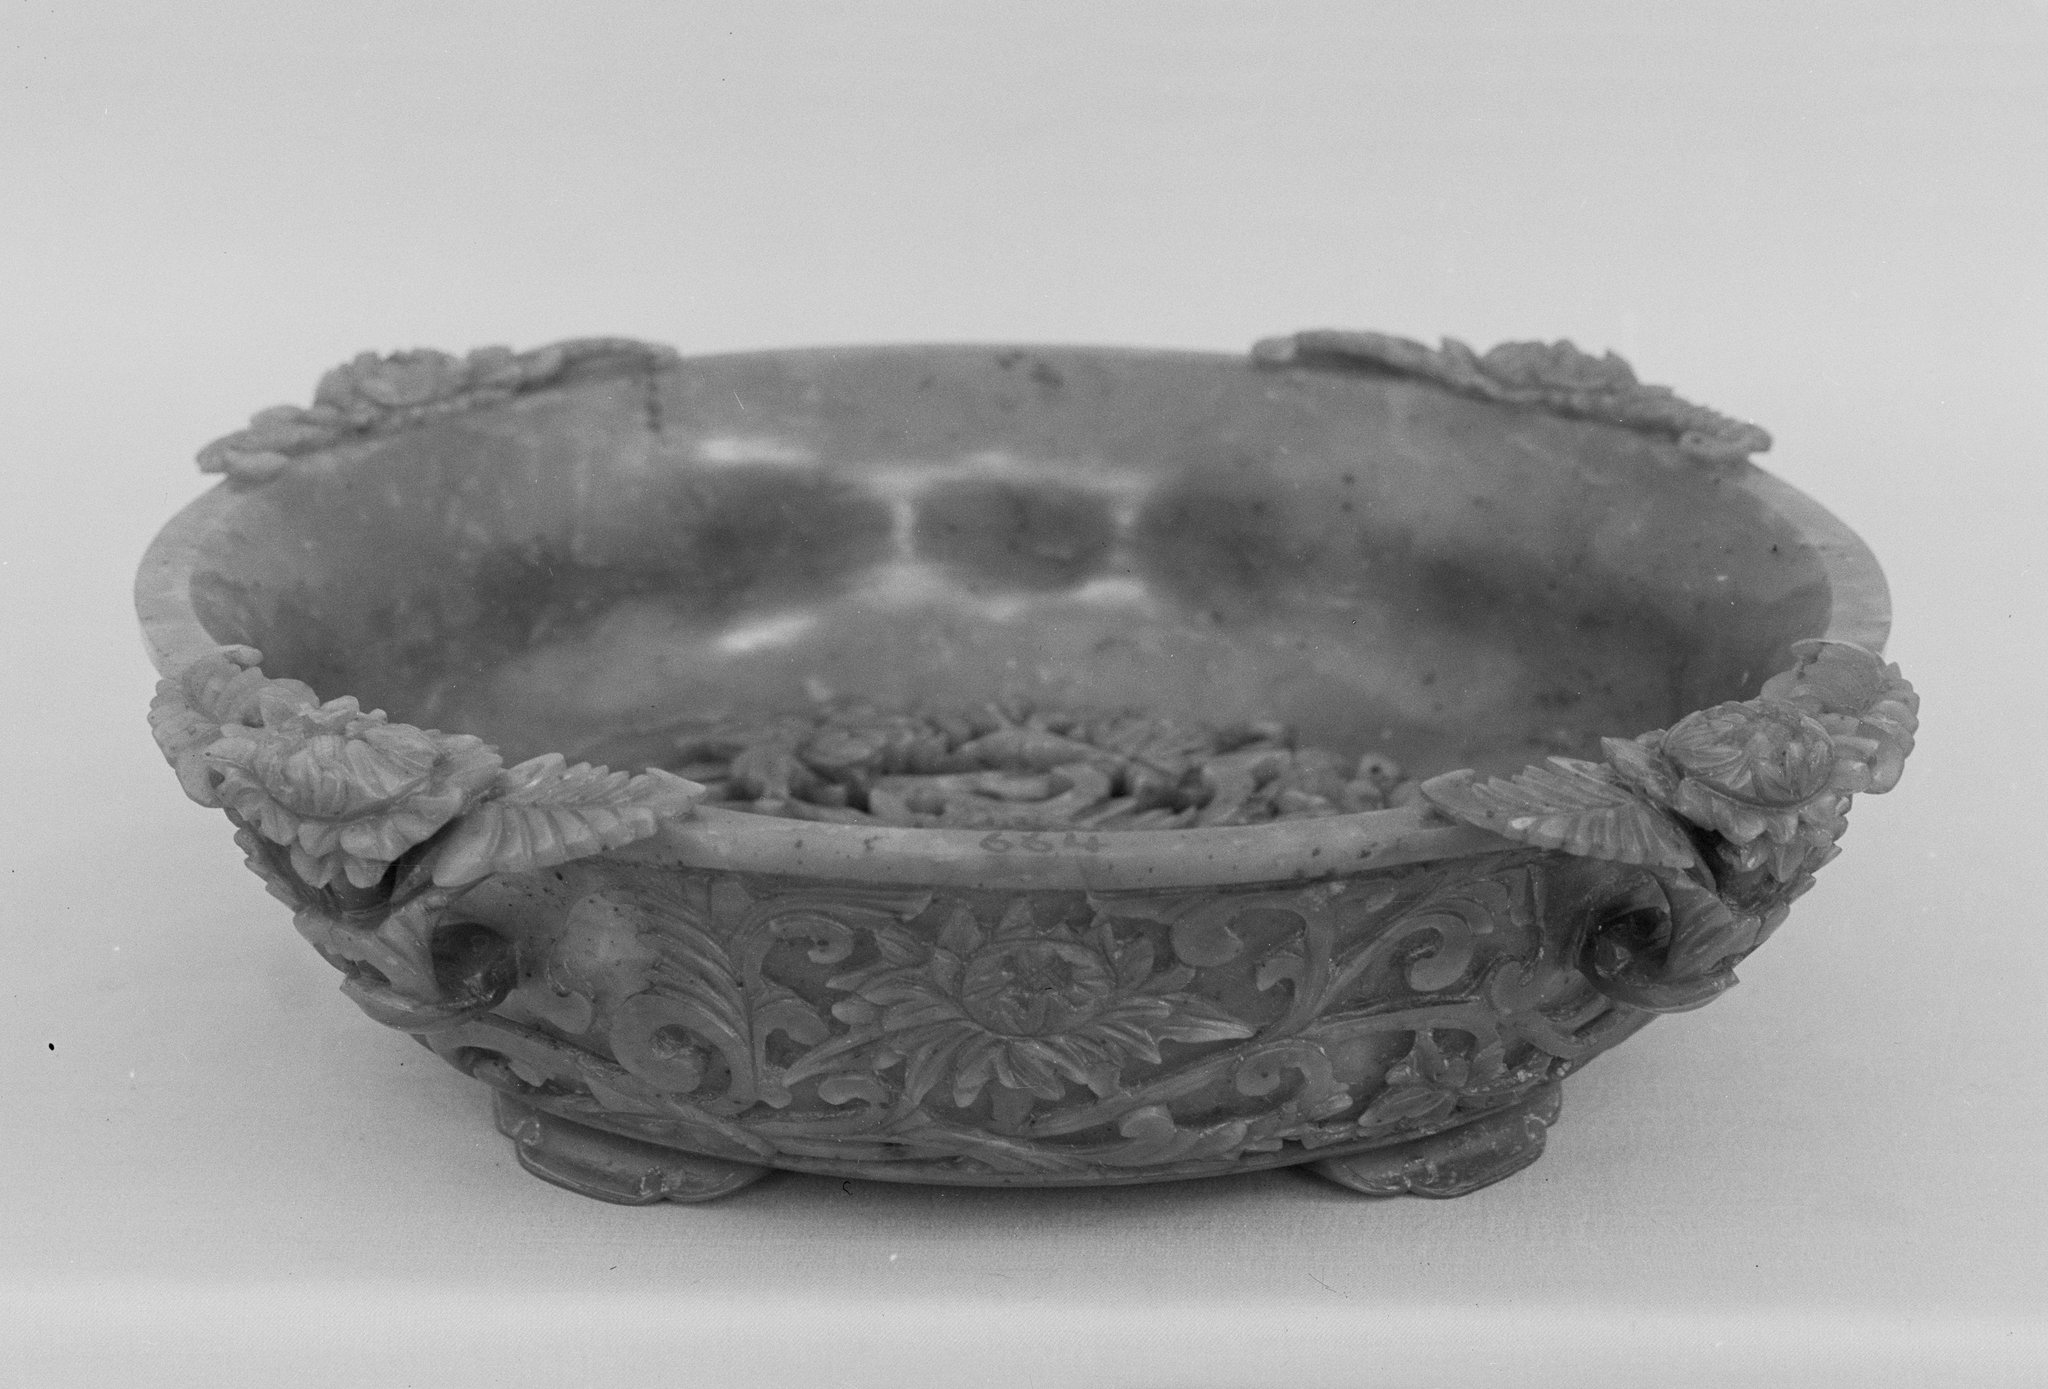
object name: dish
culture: chinese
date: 1736-1795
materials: jade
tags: flowers